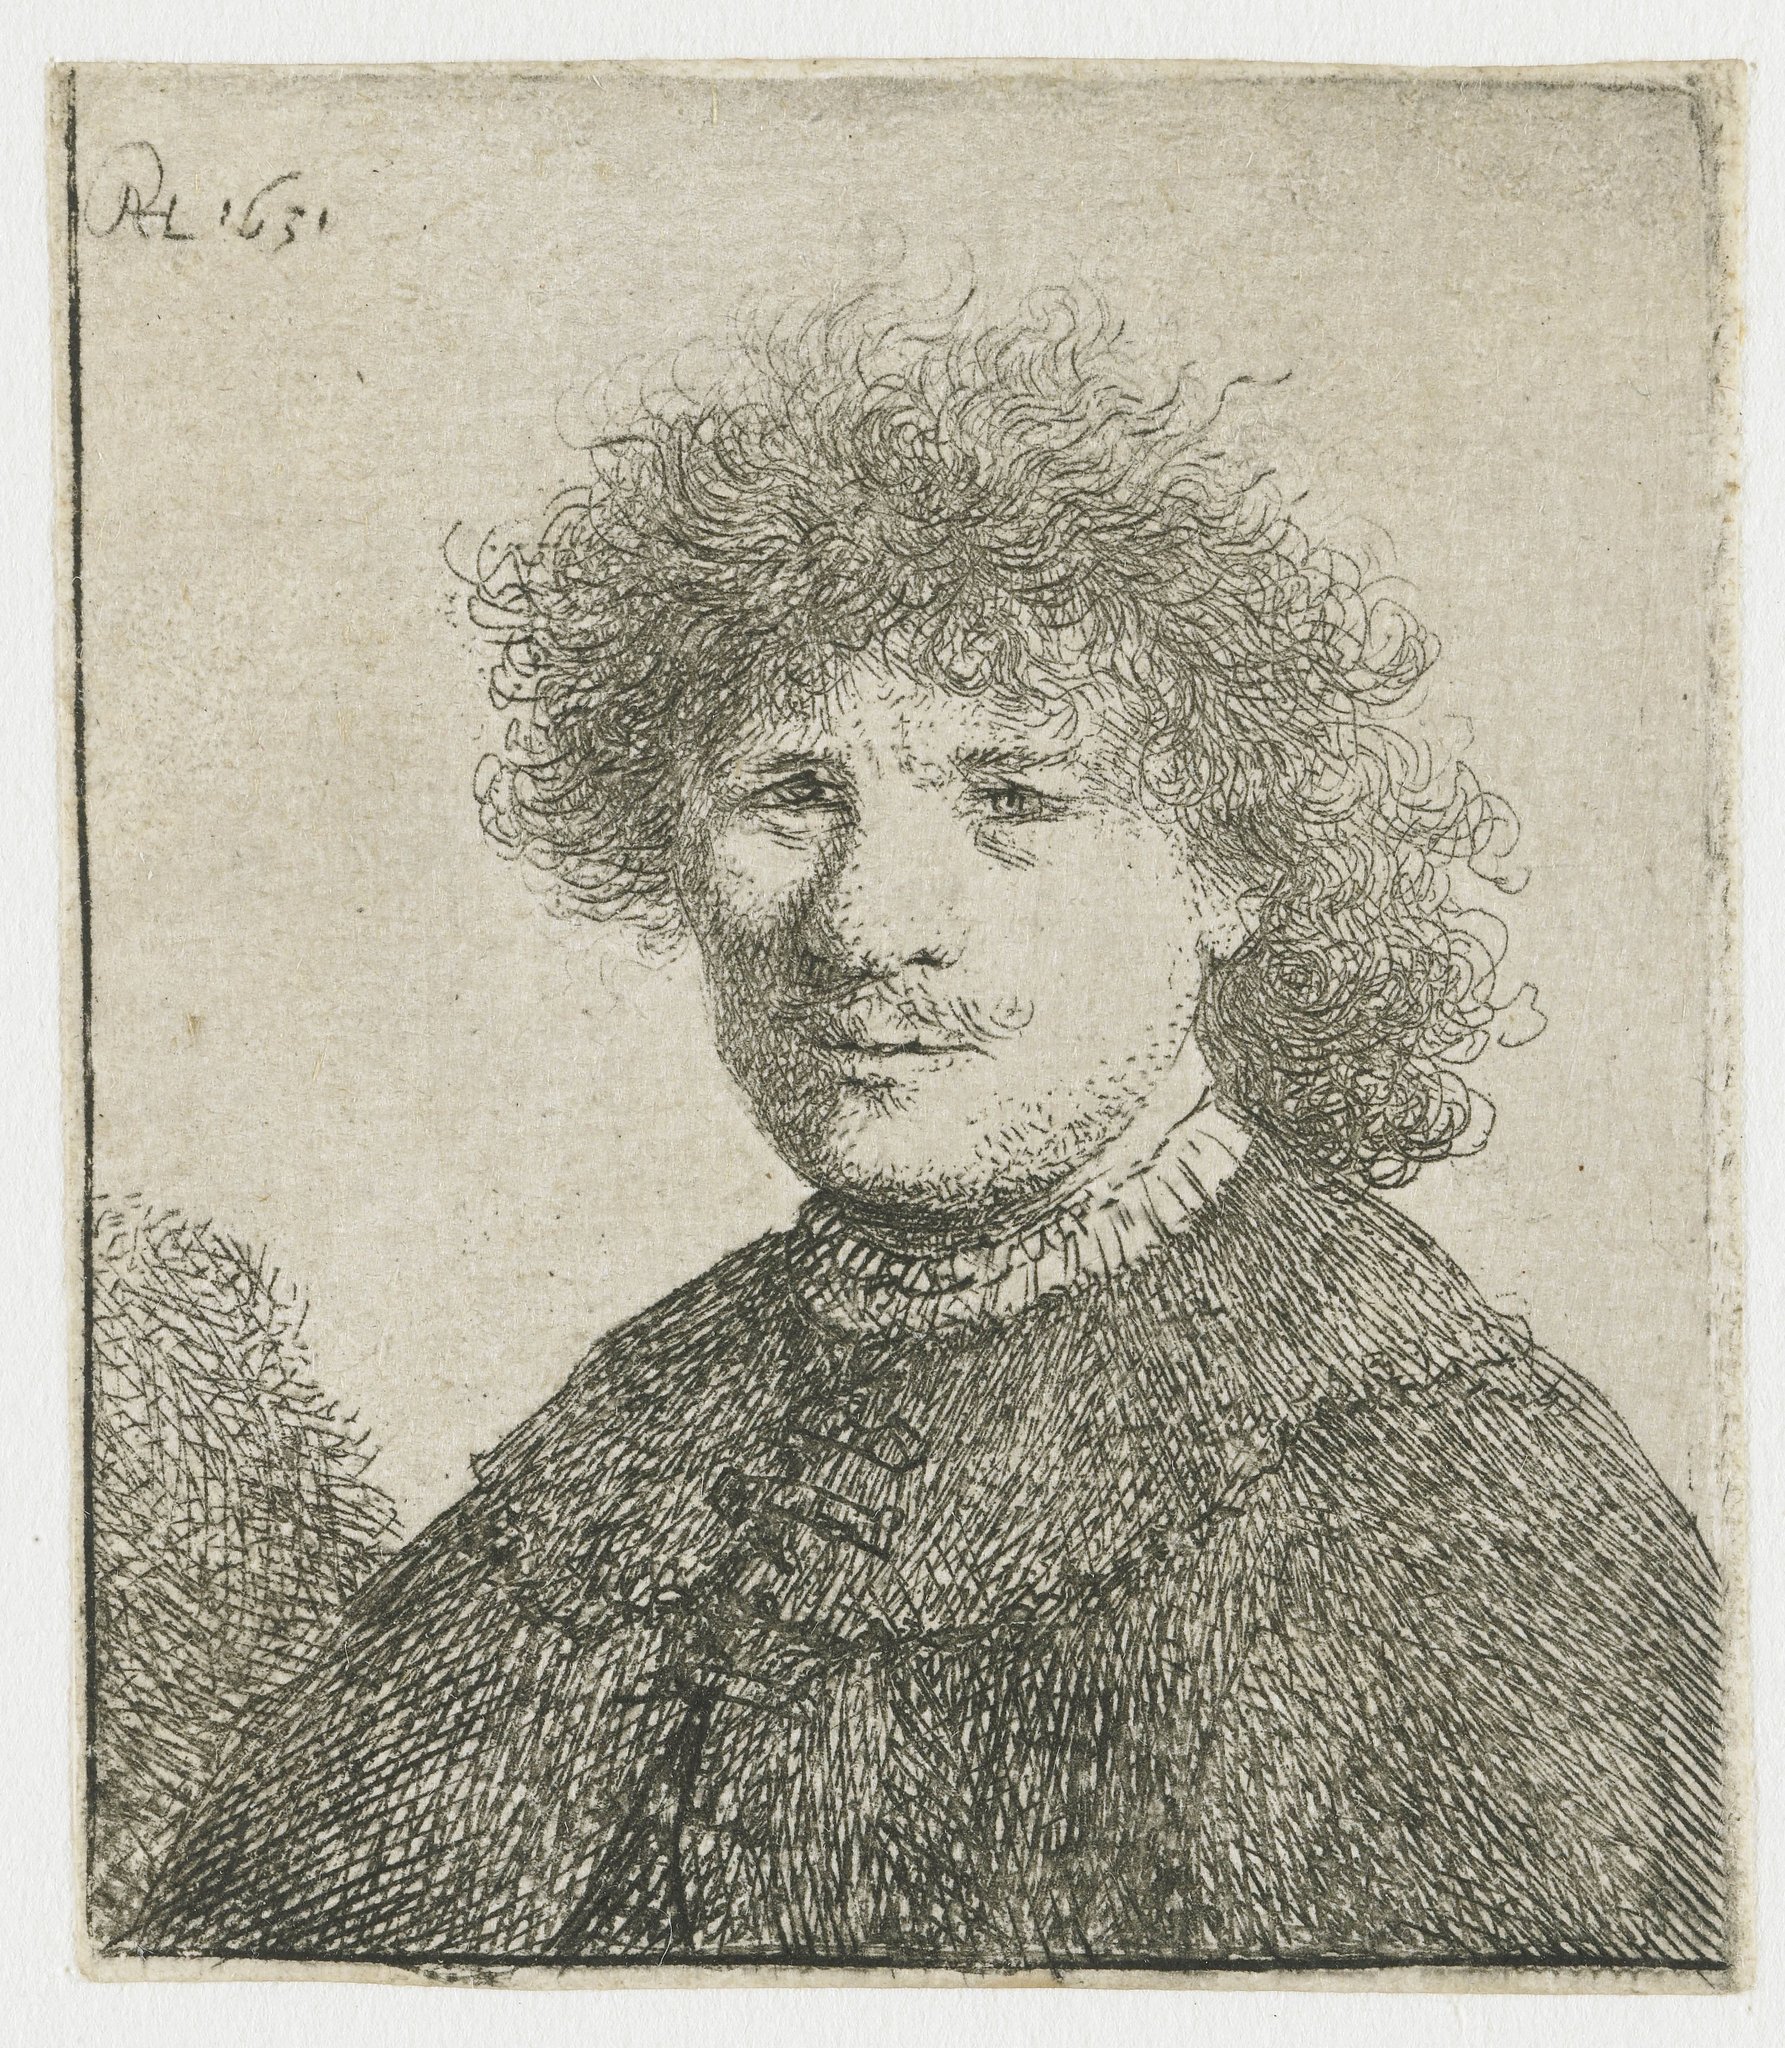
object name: print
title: Self-portrait in a cloak with a falling collar: bust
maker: rembrandt van rijn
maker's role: draughtsman, painter, print maker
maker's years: 1606-1669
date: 1631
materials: paper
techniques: etching, intaglio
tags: leiden, amsterdam, print maker, draughtsman, rembrandt van rijn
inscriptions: monogram and date: ‘RHL 1631’, collector's mark: Lugt 2228, collector's mark: Lugt 2297